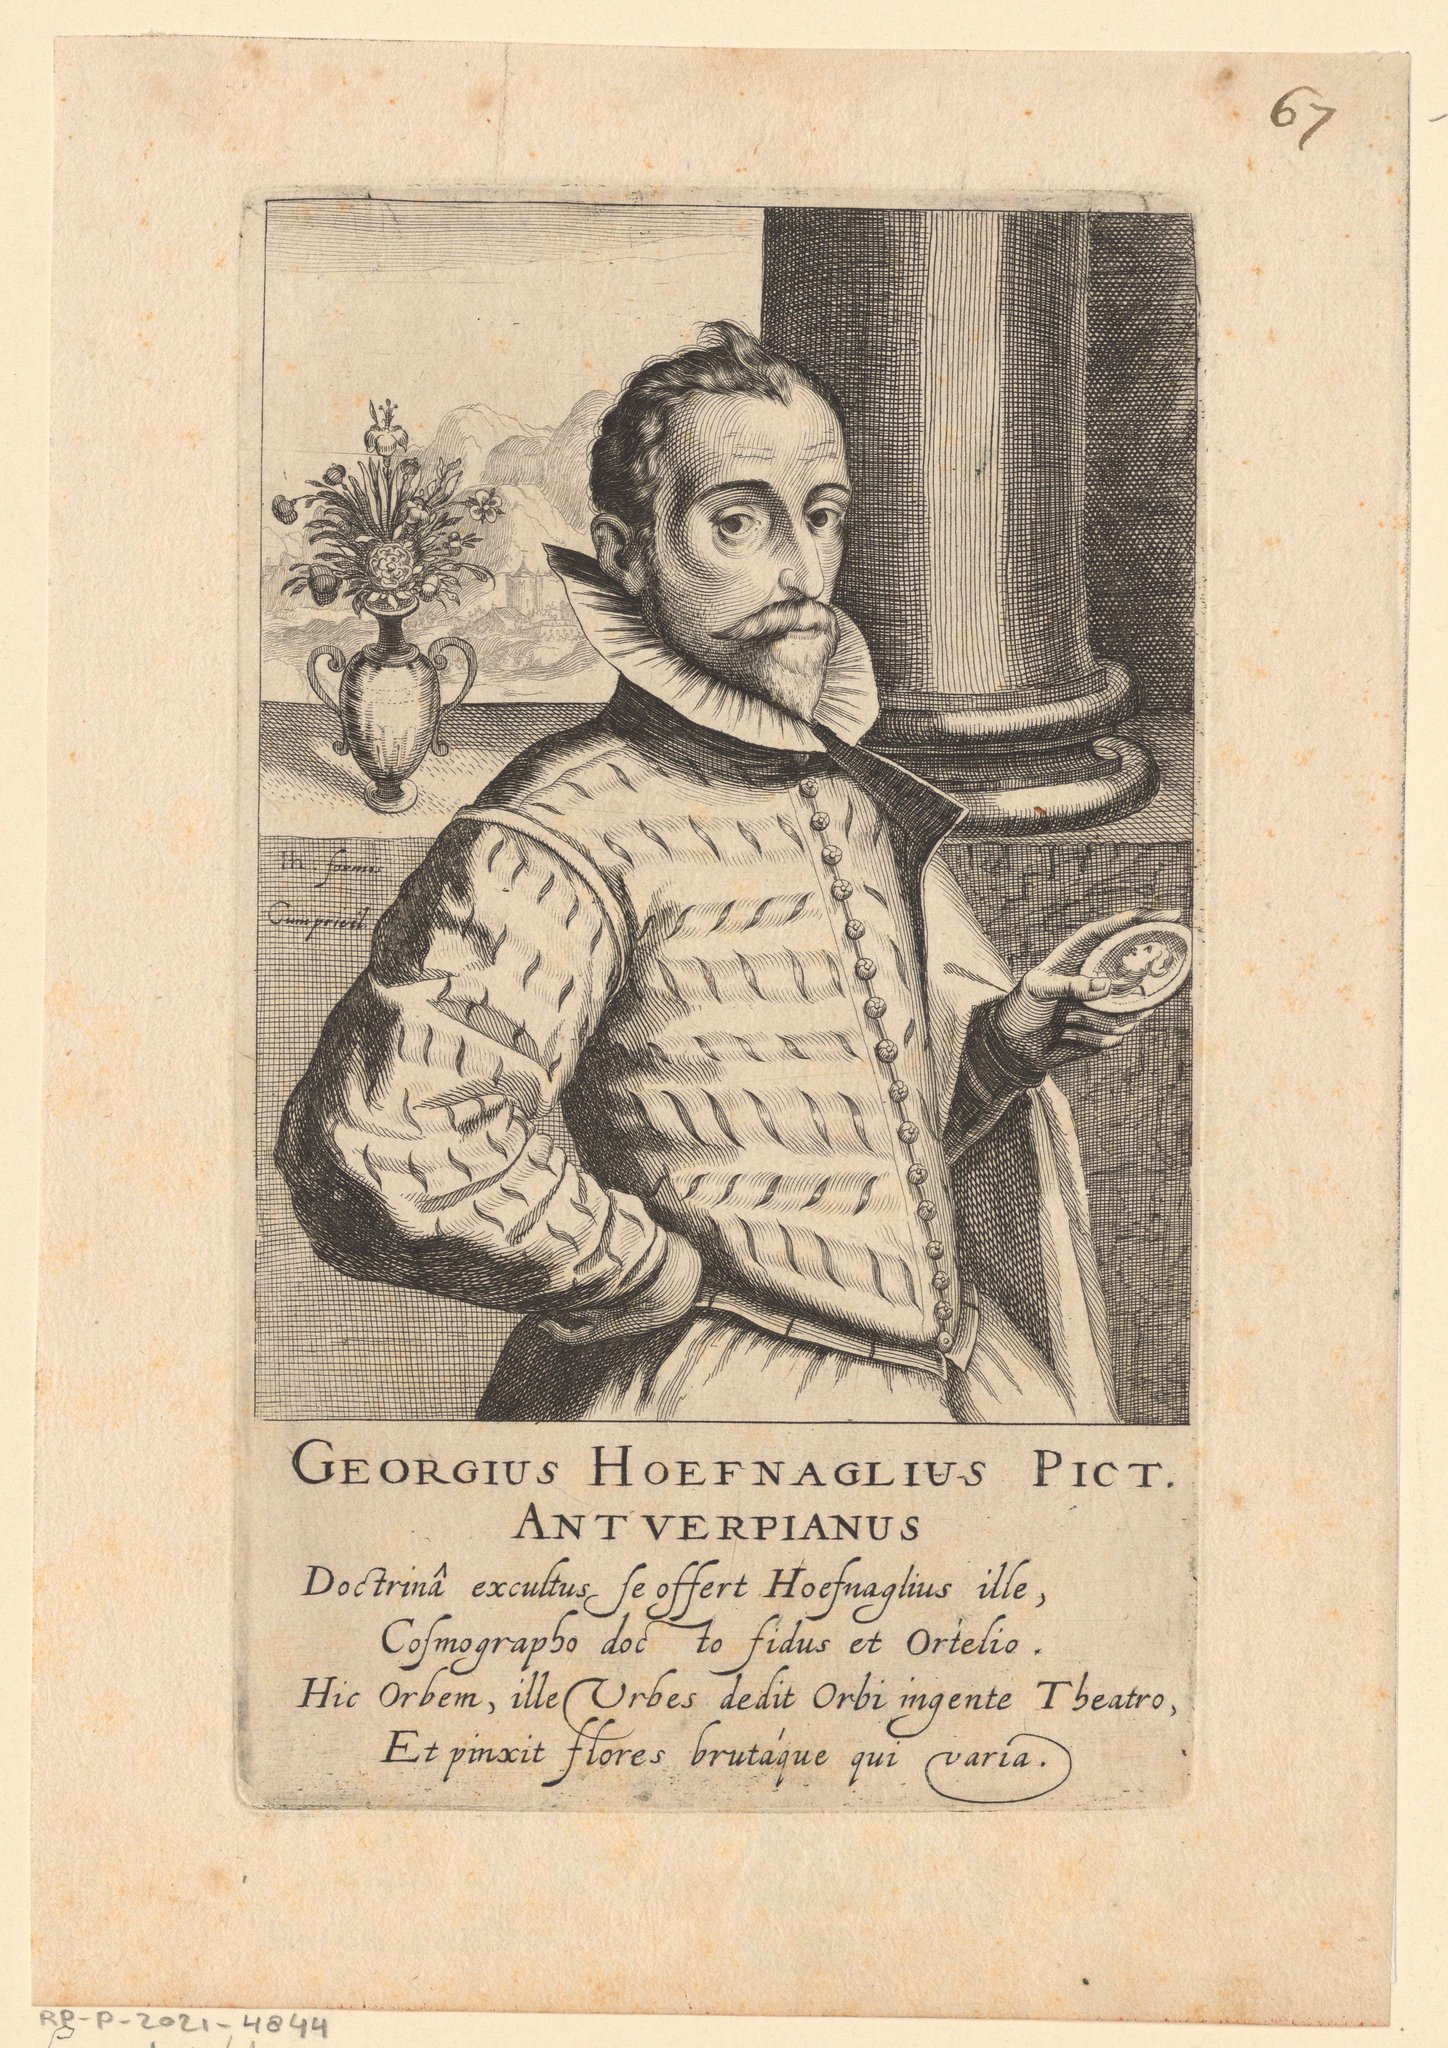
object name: print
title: Portret van Joris Hoefnagel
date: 1610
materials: paper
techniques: engraving, etching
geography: the hague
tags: antwerp, vienna, painter, joris hoefnagel, historical persons, portrait, self-portrait of painter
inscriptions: collector's mark: Lugt 11